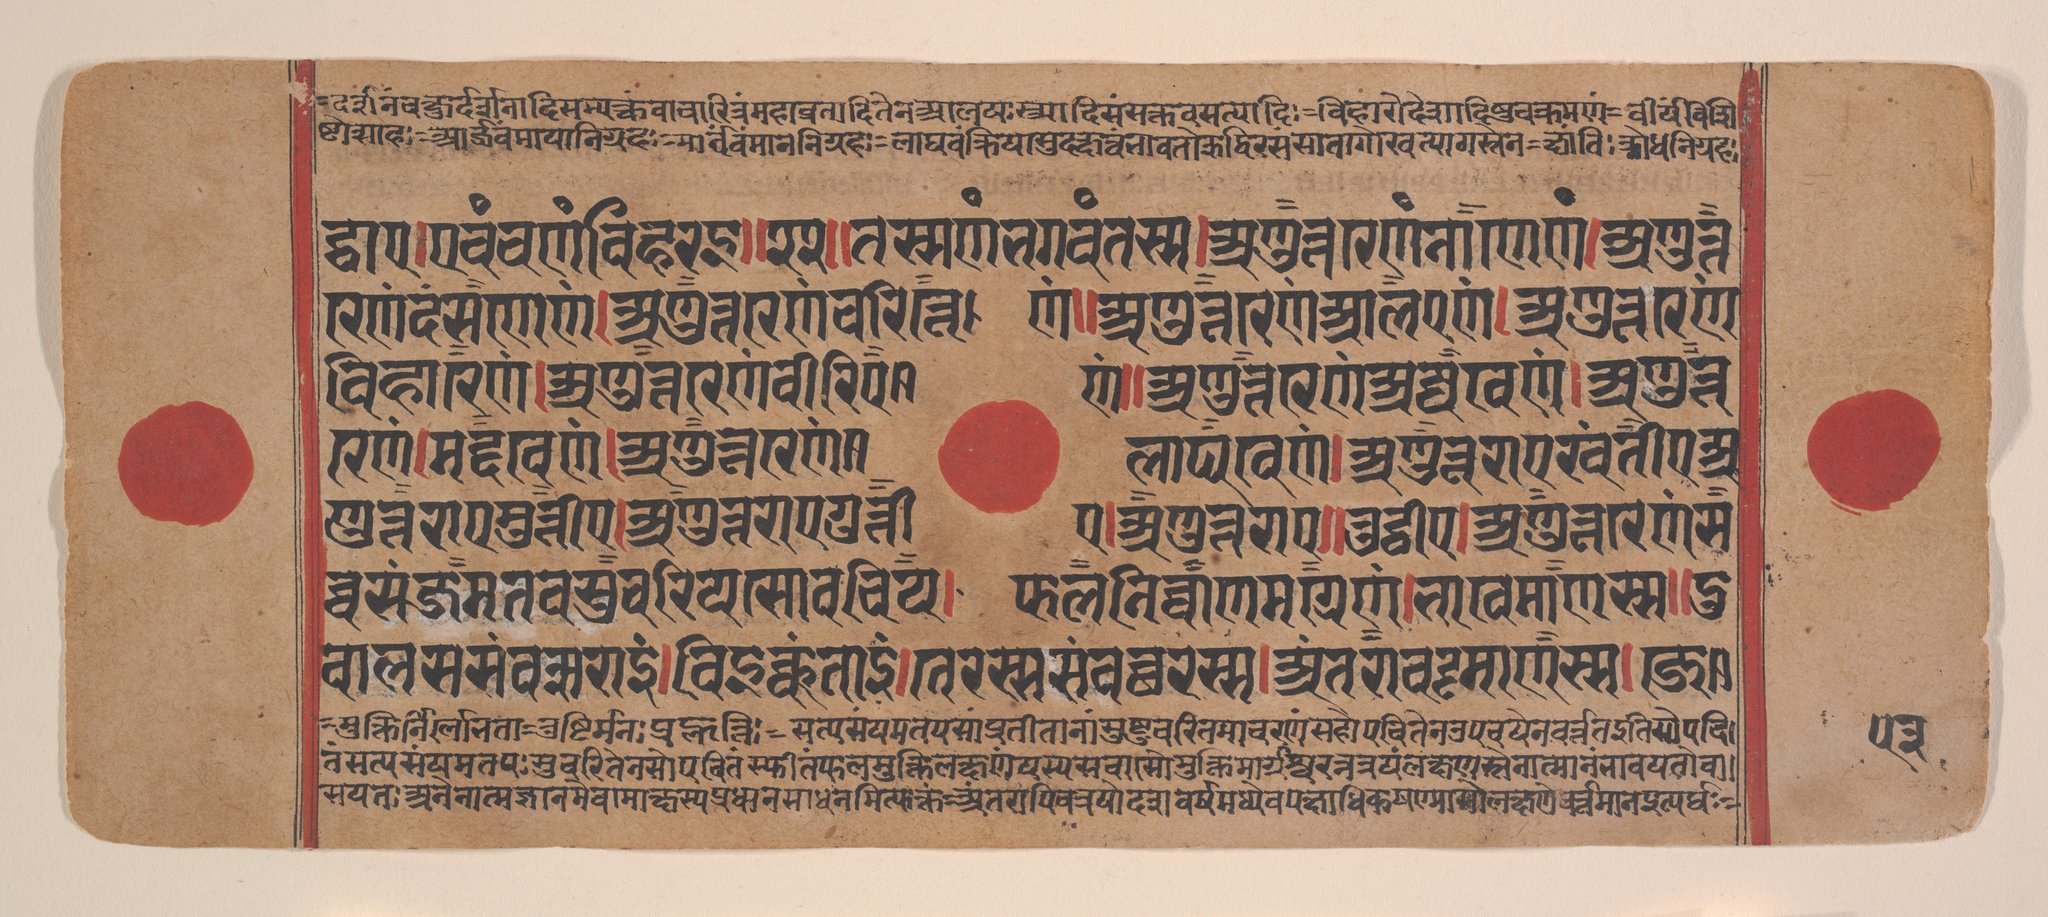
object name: folio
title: Page from a Dispersed Kalpa Sutra (Jain Book of Rituals)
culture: indian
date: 1401-1500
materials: gold, ink, paper, watercolor